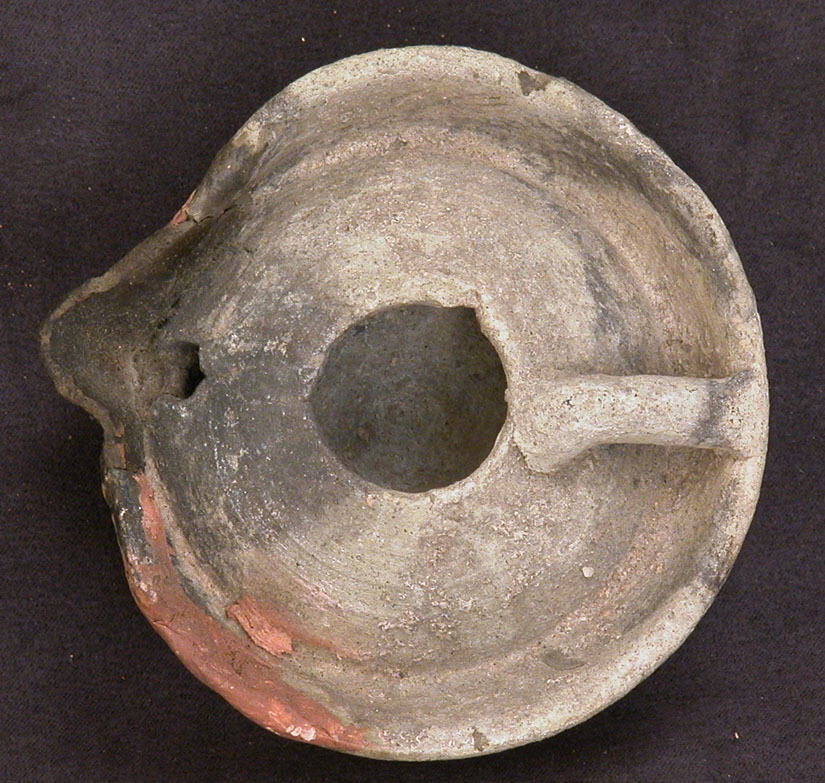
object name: lamp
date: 601-800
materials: earthenware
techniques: molding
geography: palestine